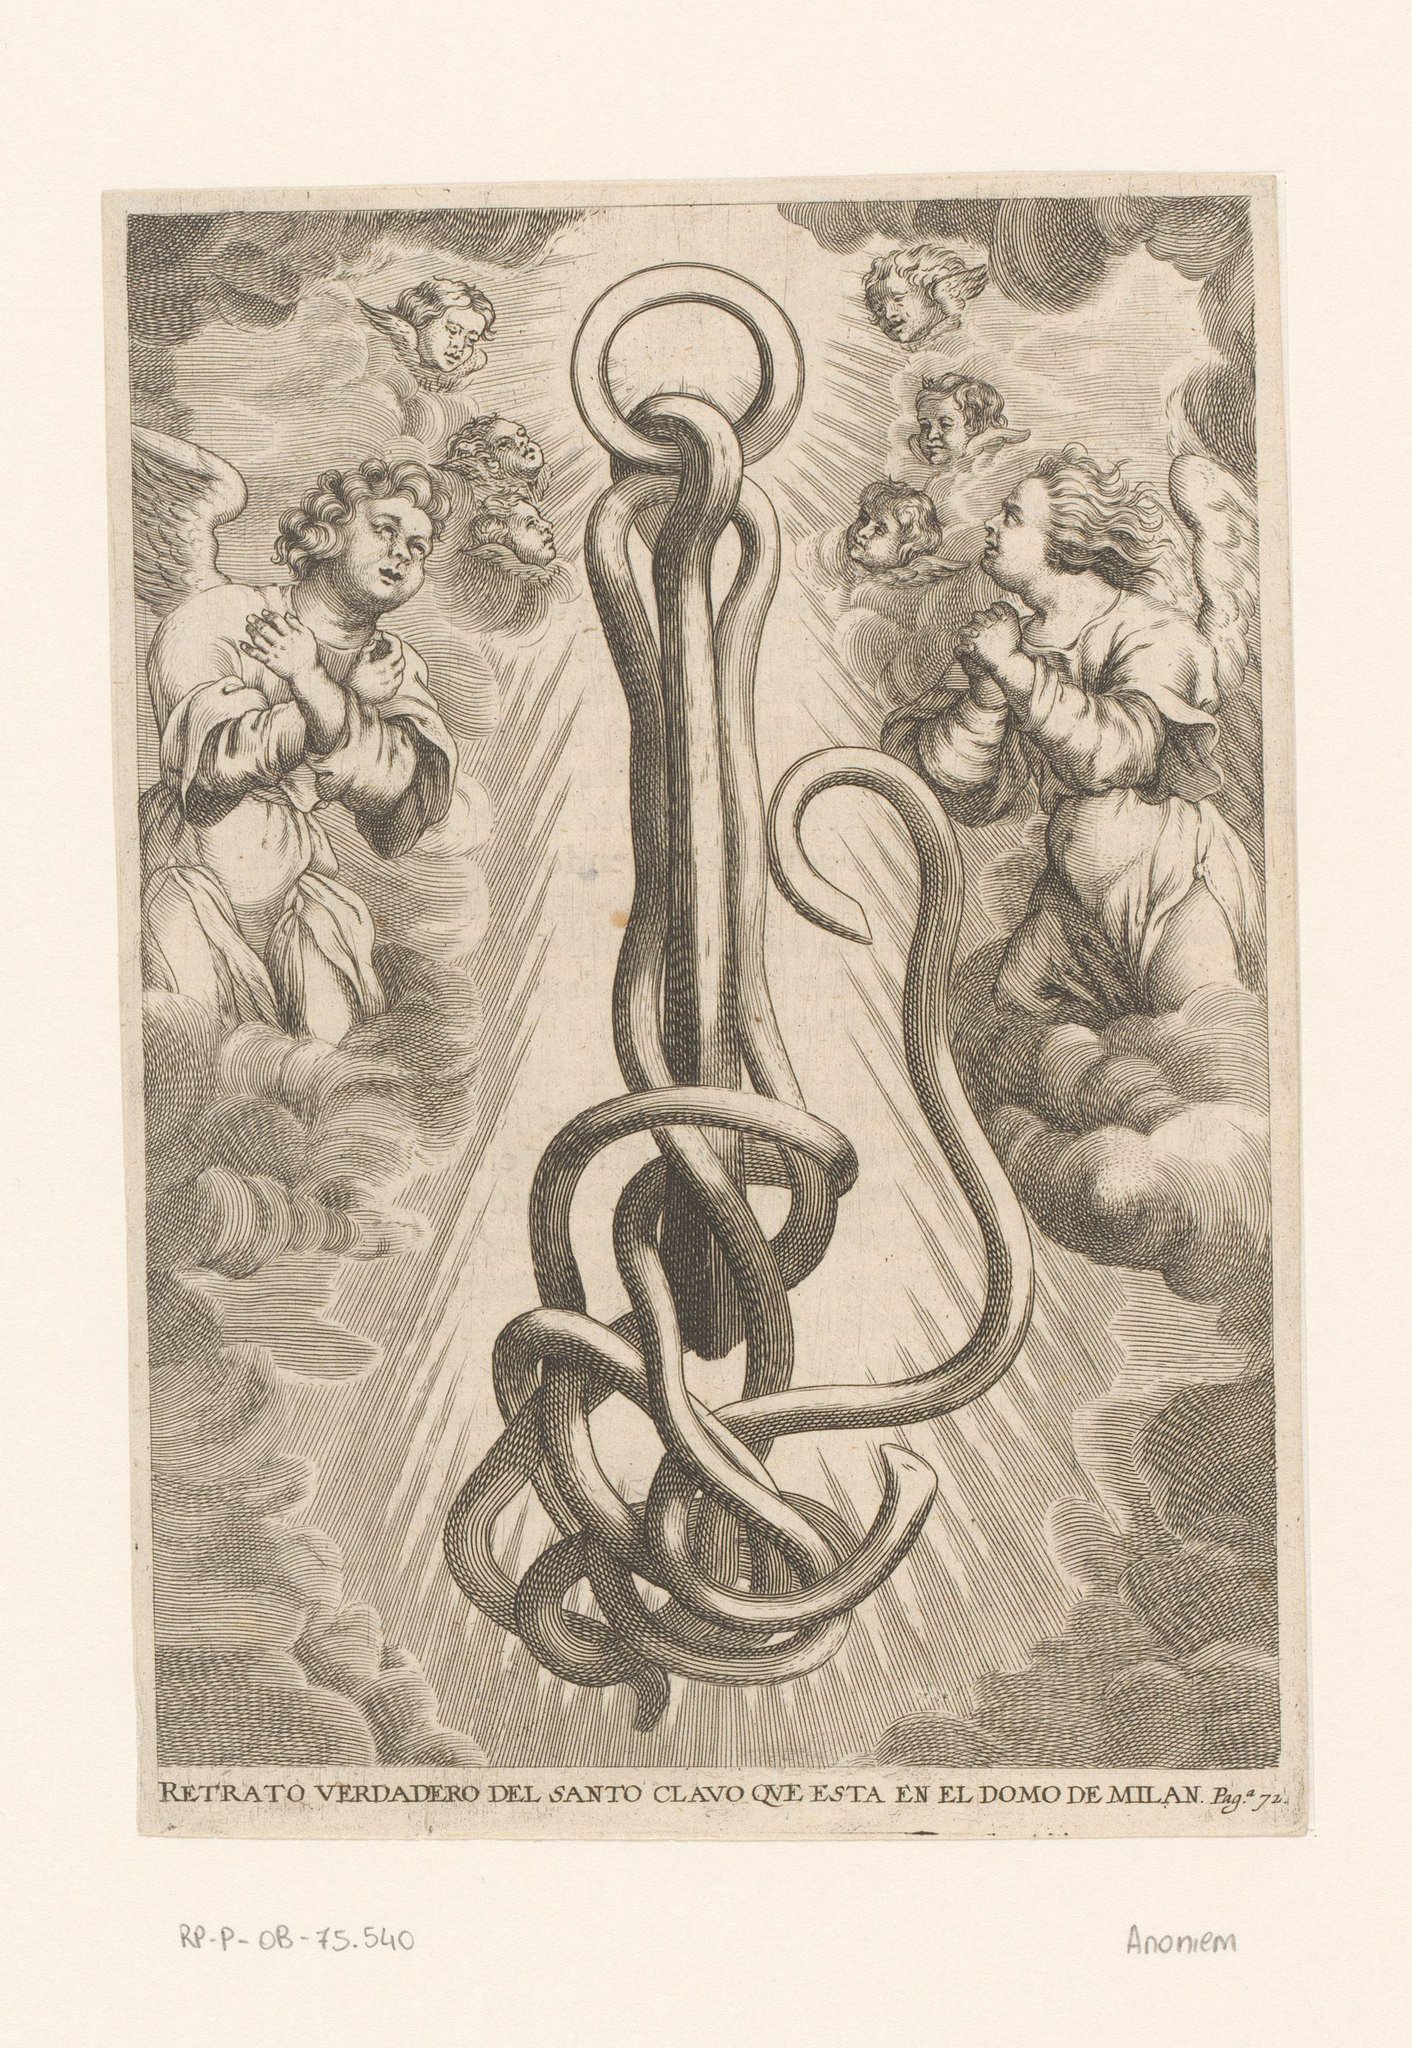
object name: book illustration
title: Heilige spijker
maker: Anonymous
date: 1600-1699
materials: paper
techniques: engraving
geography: netherlands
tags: nails of the cross ~ relics of christ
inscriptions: collector's mark: Lugt 240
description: Volgens het opschrift betreft dit de Heilige spijker die wordt bewaard in de Dom van Milaan. Dit betreft waarschijnlijk een illustratie uit een onbekend boek, op p. a72.